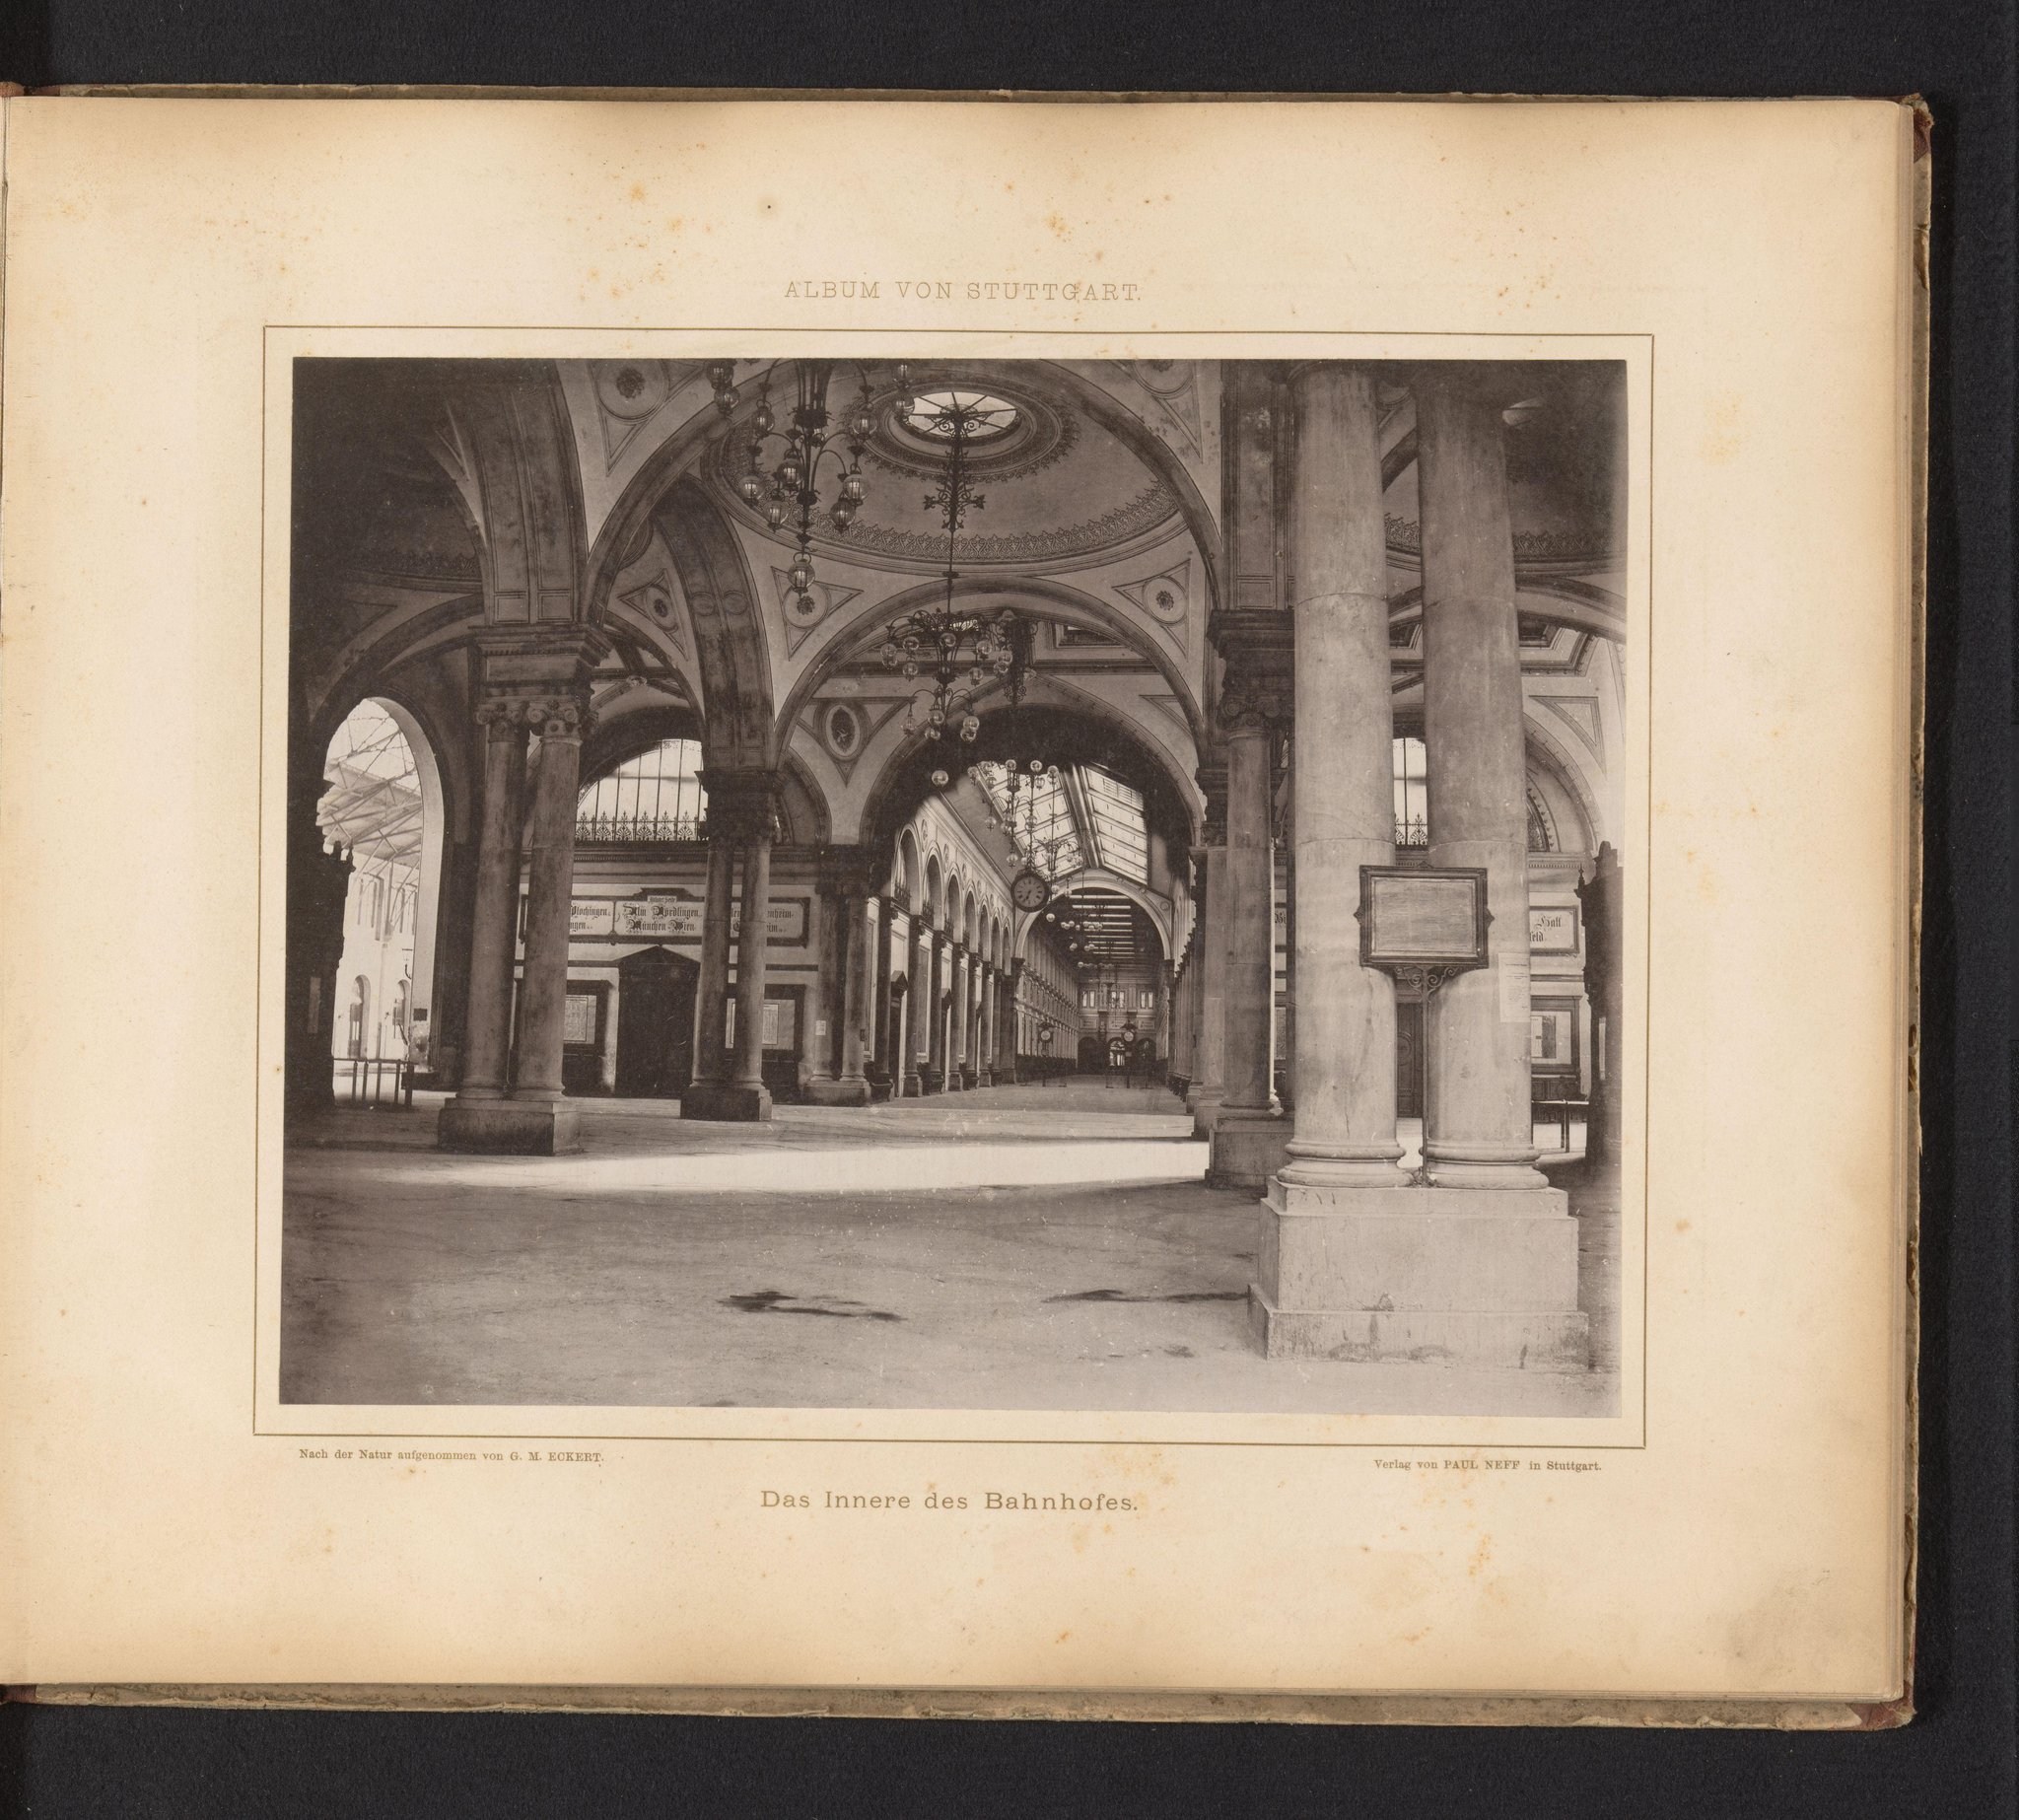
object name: photomechanical print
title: Interieur van het stationsgebouw van Stuttgart, Duitsland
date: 1870-1875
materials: paper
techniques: photograph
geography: stuttgart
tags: station; shelter (railway, tramway)